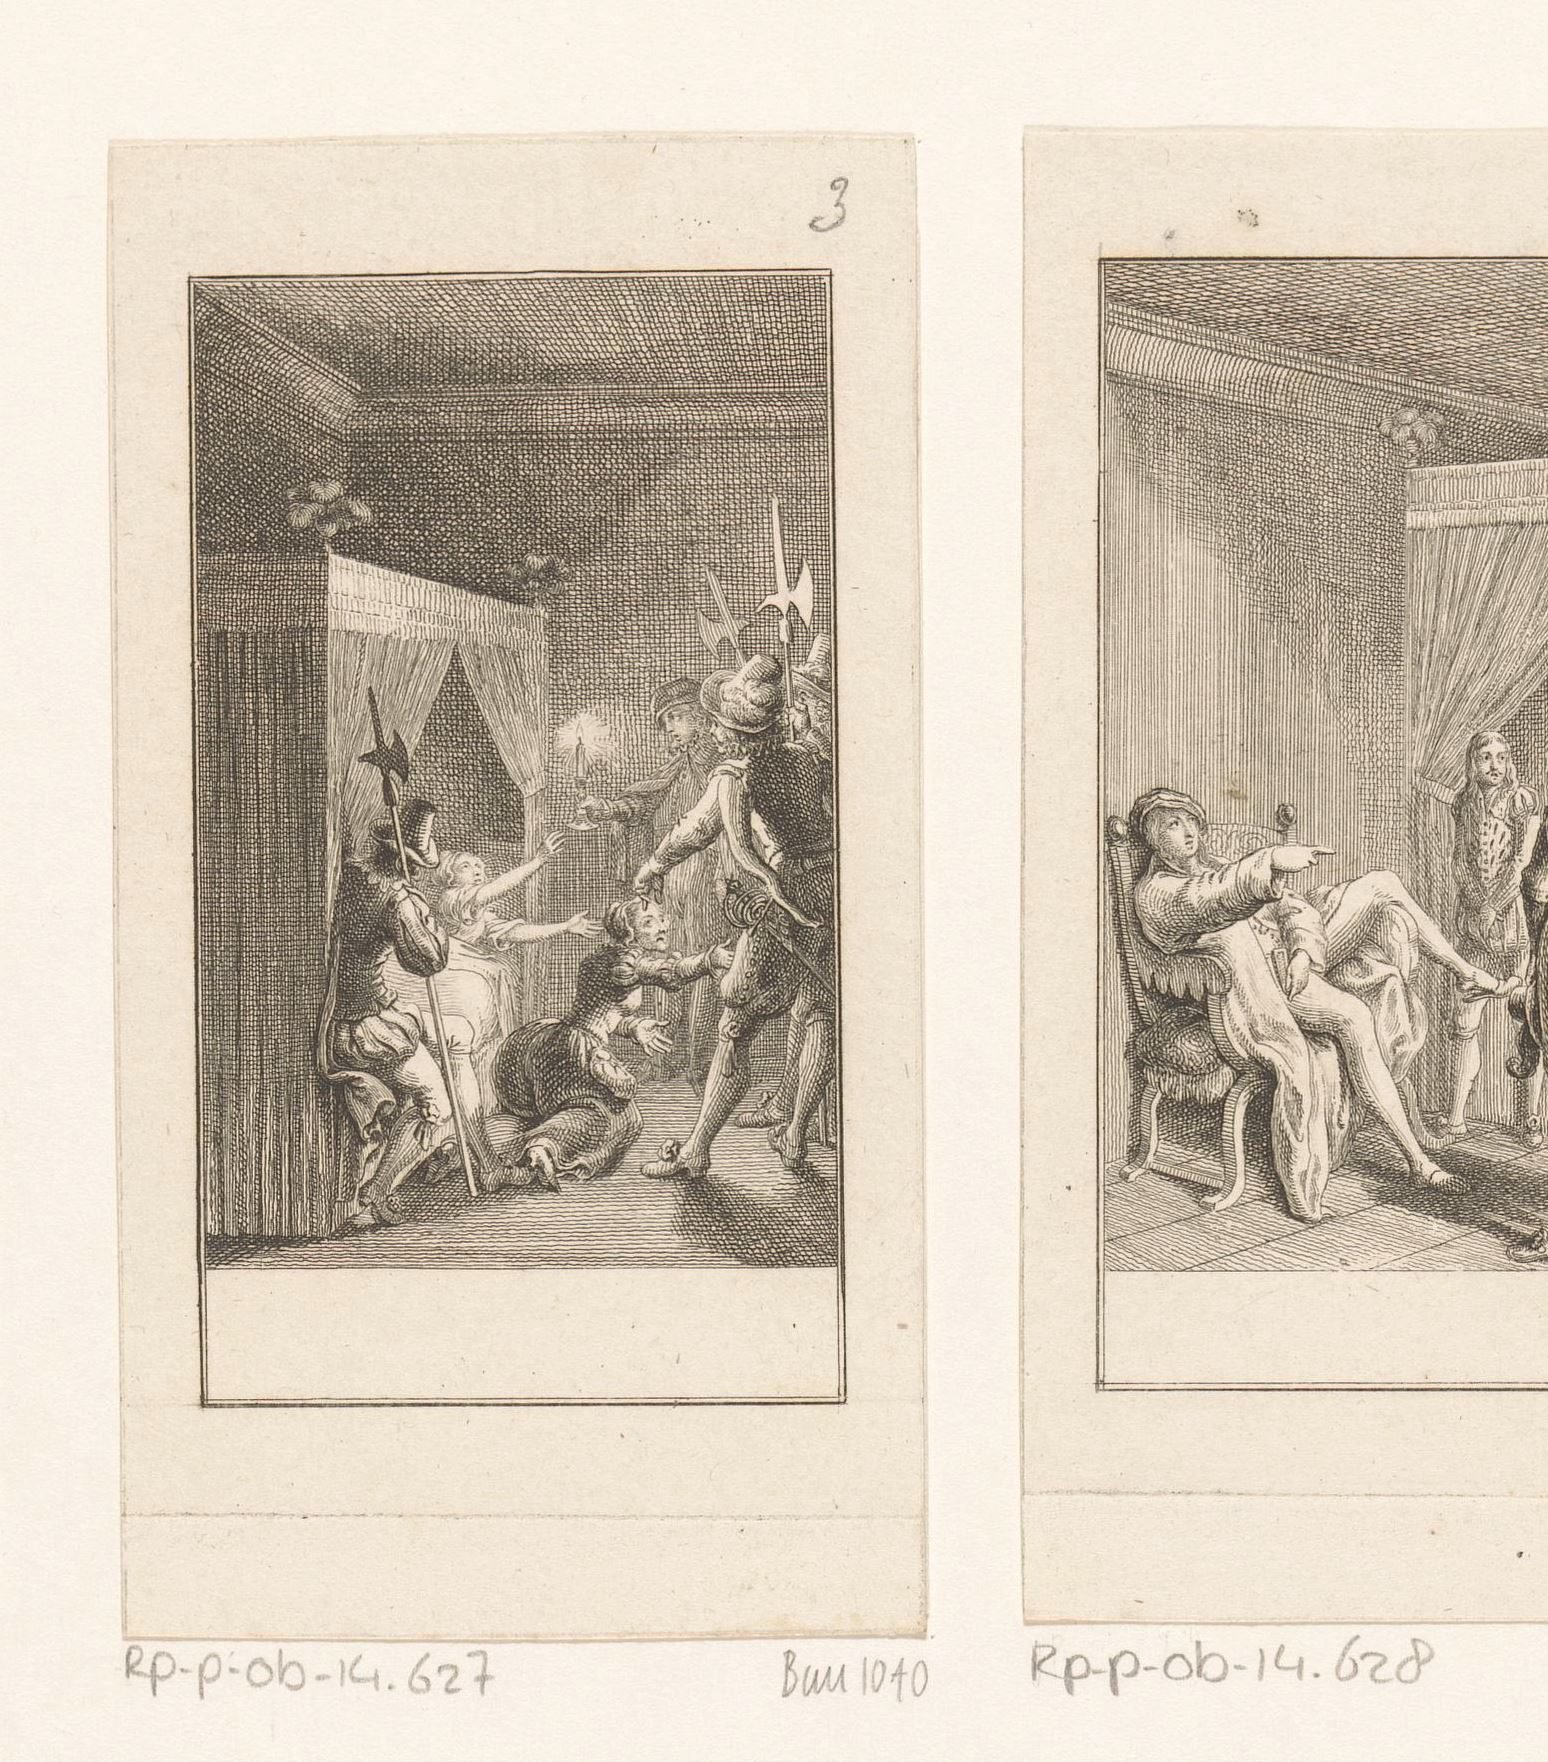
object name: print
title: Gil Blas probeert vermomd als agent zijn ring terug te krijgen van de krankzinnige Camilla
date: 1783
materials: paper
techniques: etching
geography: berlin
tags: alarm, fright; 'spavento', 'terrore' (ripa), literature, interior of the house, police, four poster bed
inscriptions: collector's mark: Lugt 2228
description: Vervaardigd voor 'Gil Blas de Santillane' van Alain-René Lesage. Een latere staat gebruikt in: Almanac de Gotha (...). Gotha: C. W. Ettinger, 1784.